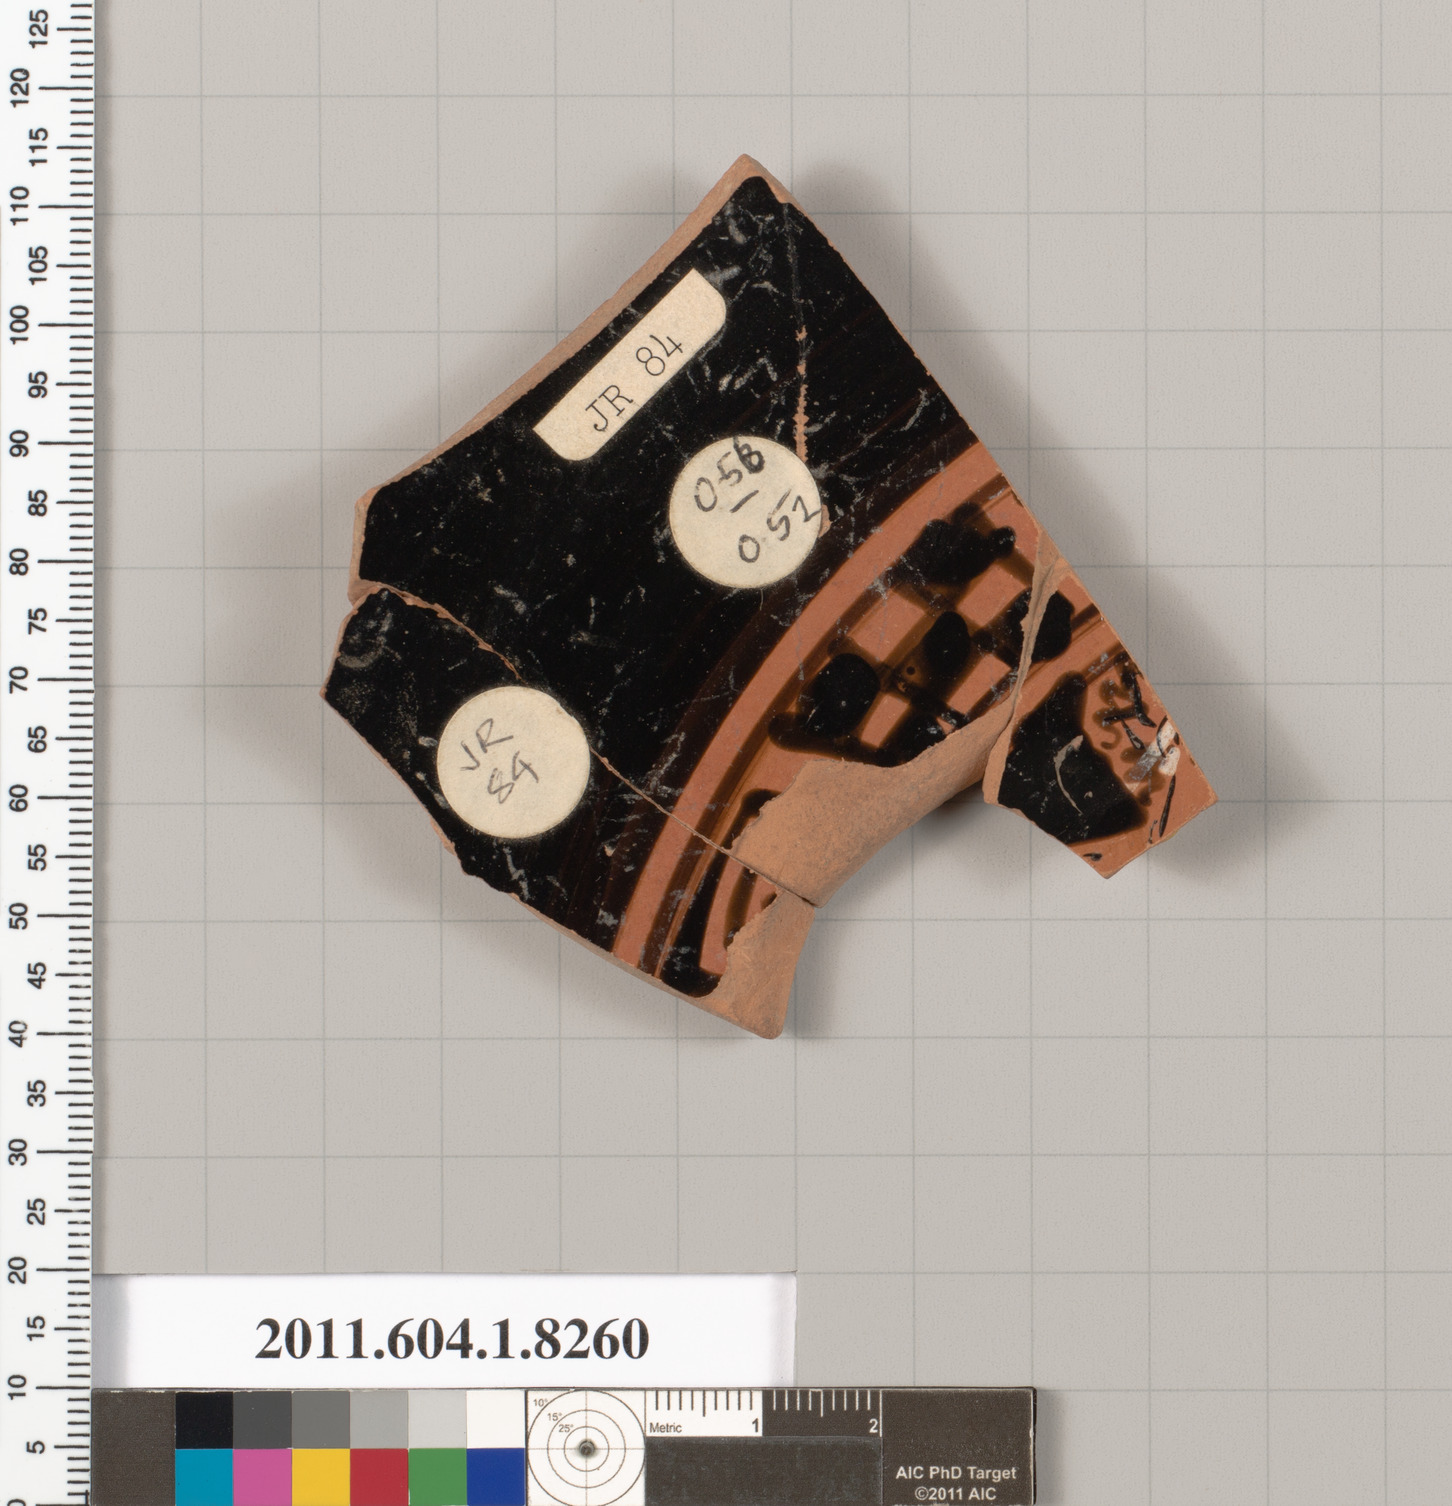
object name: kylix fragment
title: Terracotta fragment of a kylix (drinking cup)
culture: greek, attic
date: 375-351 BCE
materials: terracotta